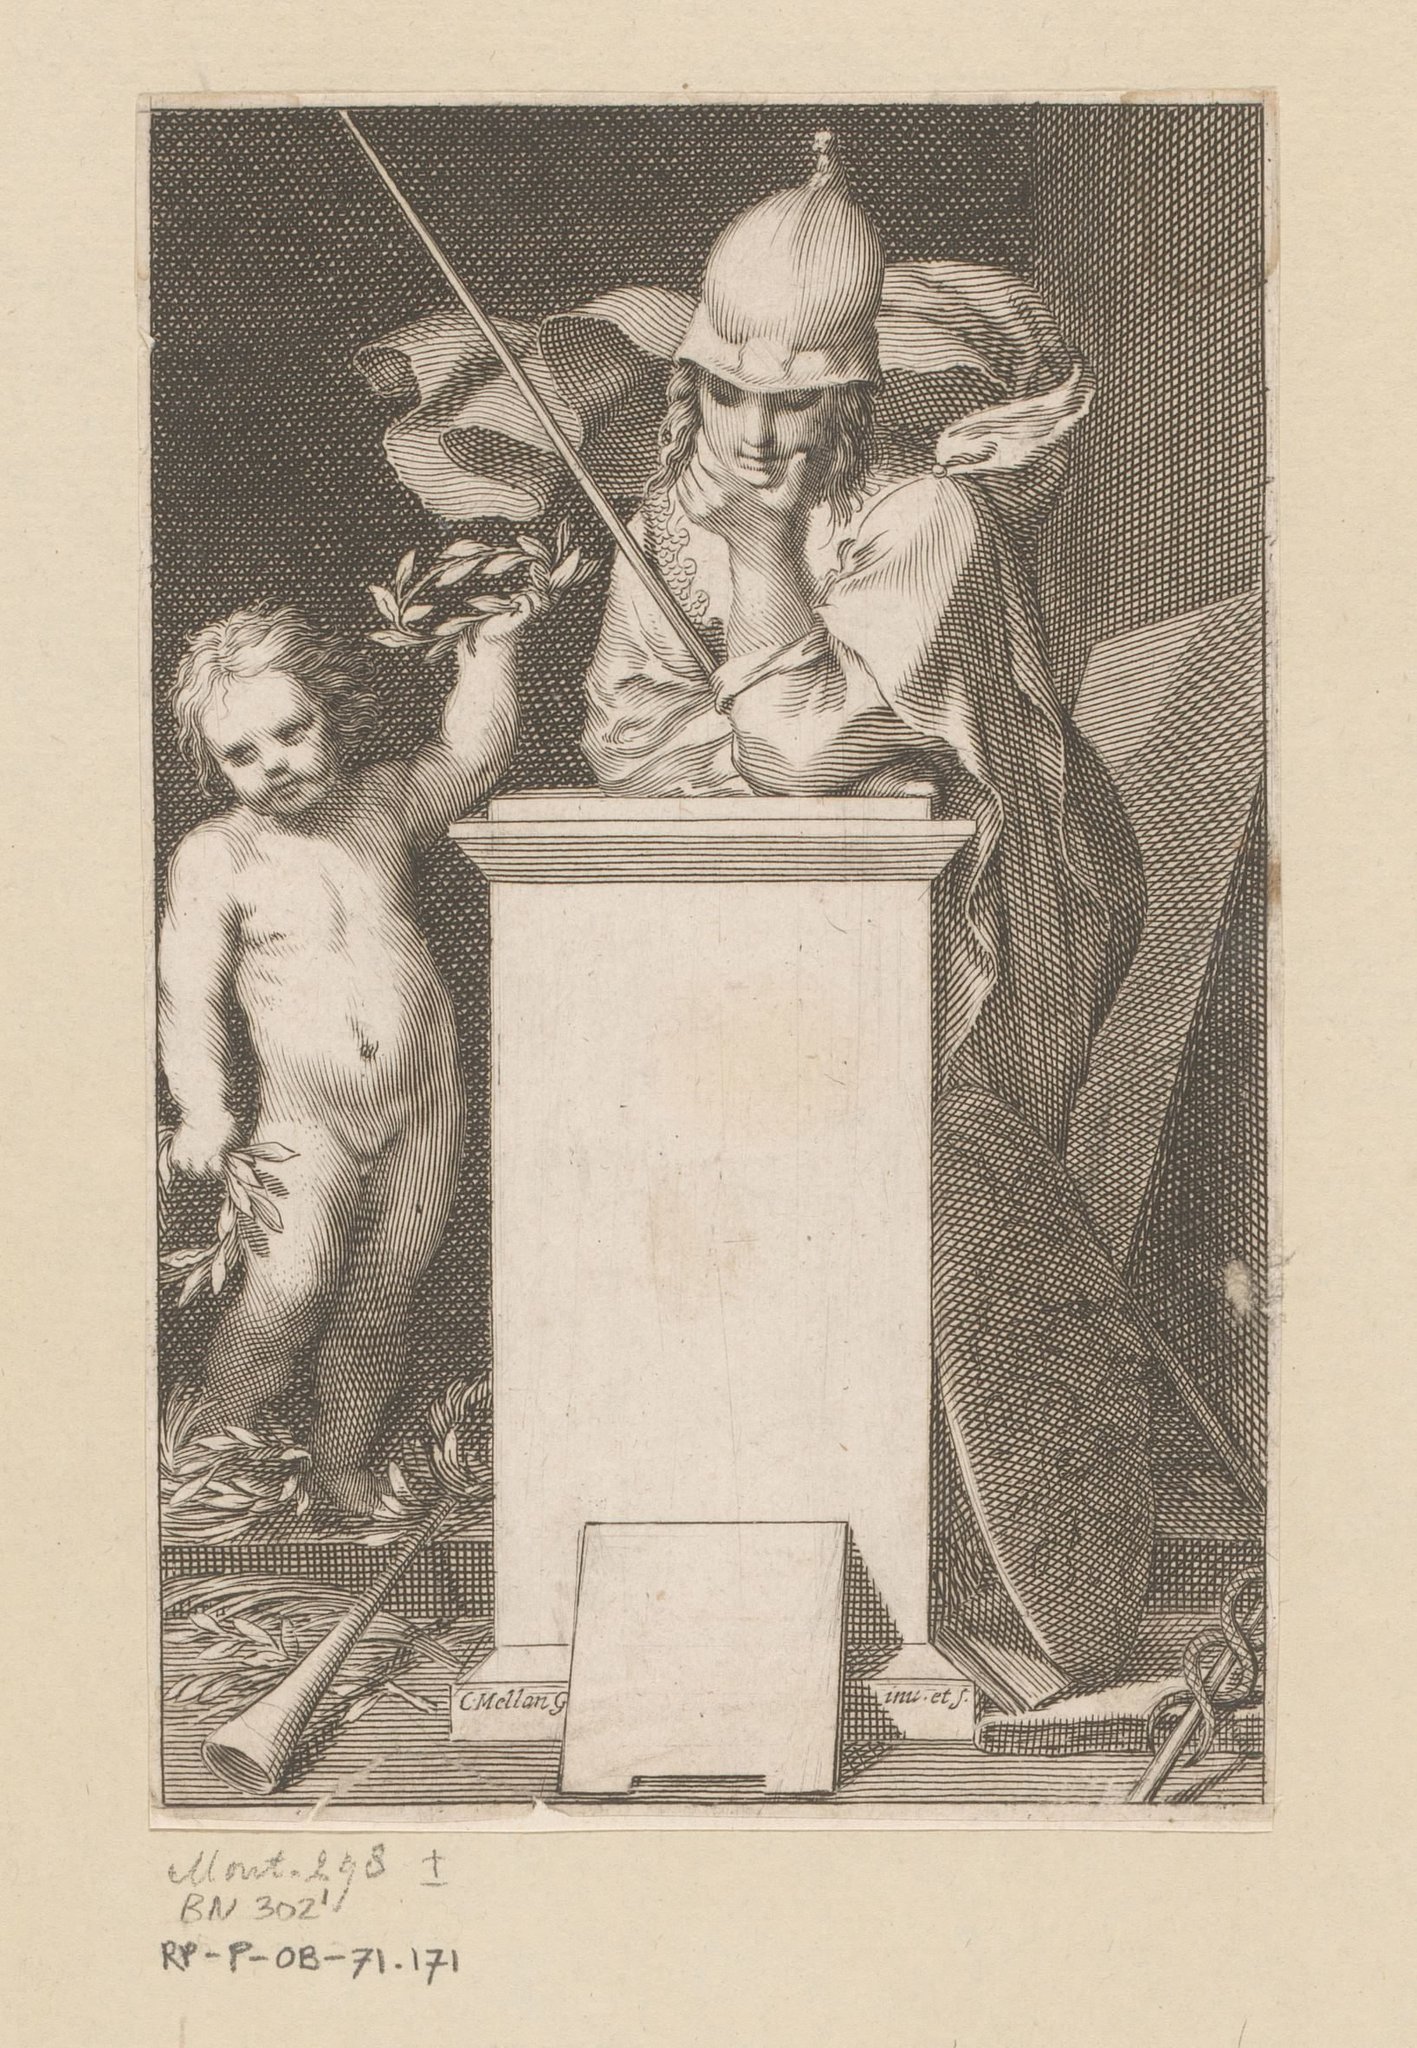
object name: print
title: Minerva, leunend op een voetstuk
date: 1637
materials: paper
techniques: engraving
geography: paris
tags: (story of) minerva (pallas, athena)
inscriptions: collector's mark: Lugt 240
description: Titelpagina voor: Balzac, Guez de. Recueil de nouvelles lettres. Parijs: Jean Camusat, 1637.